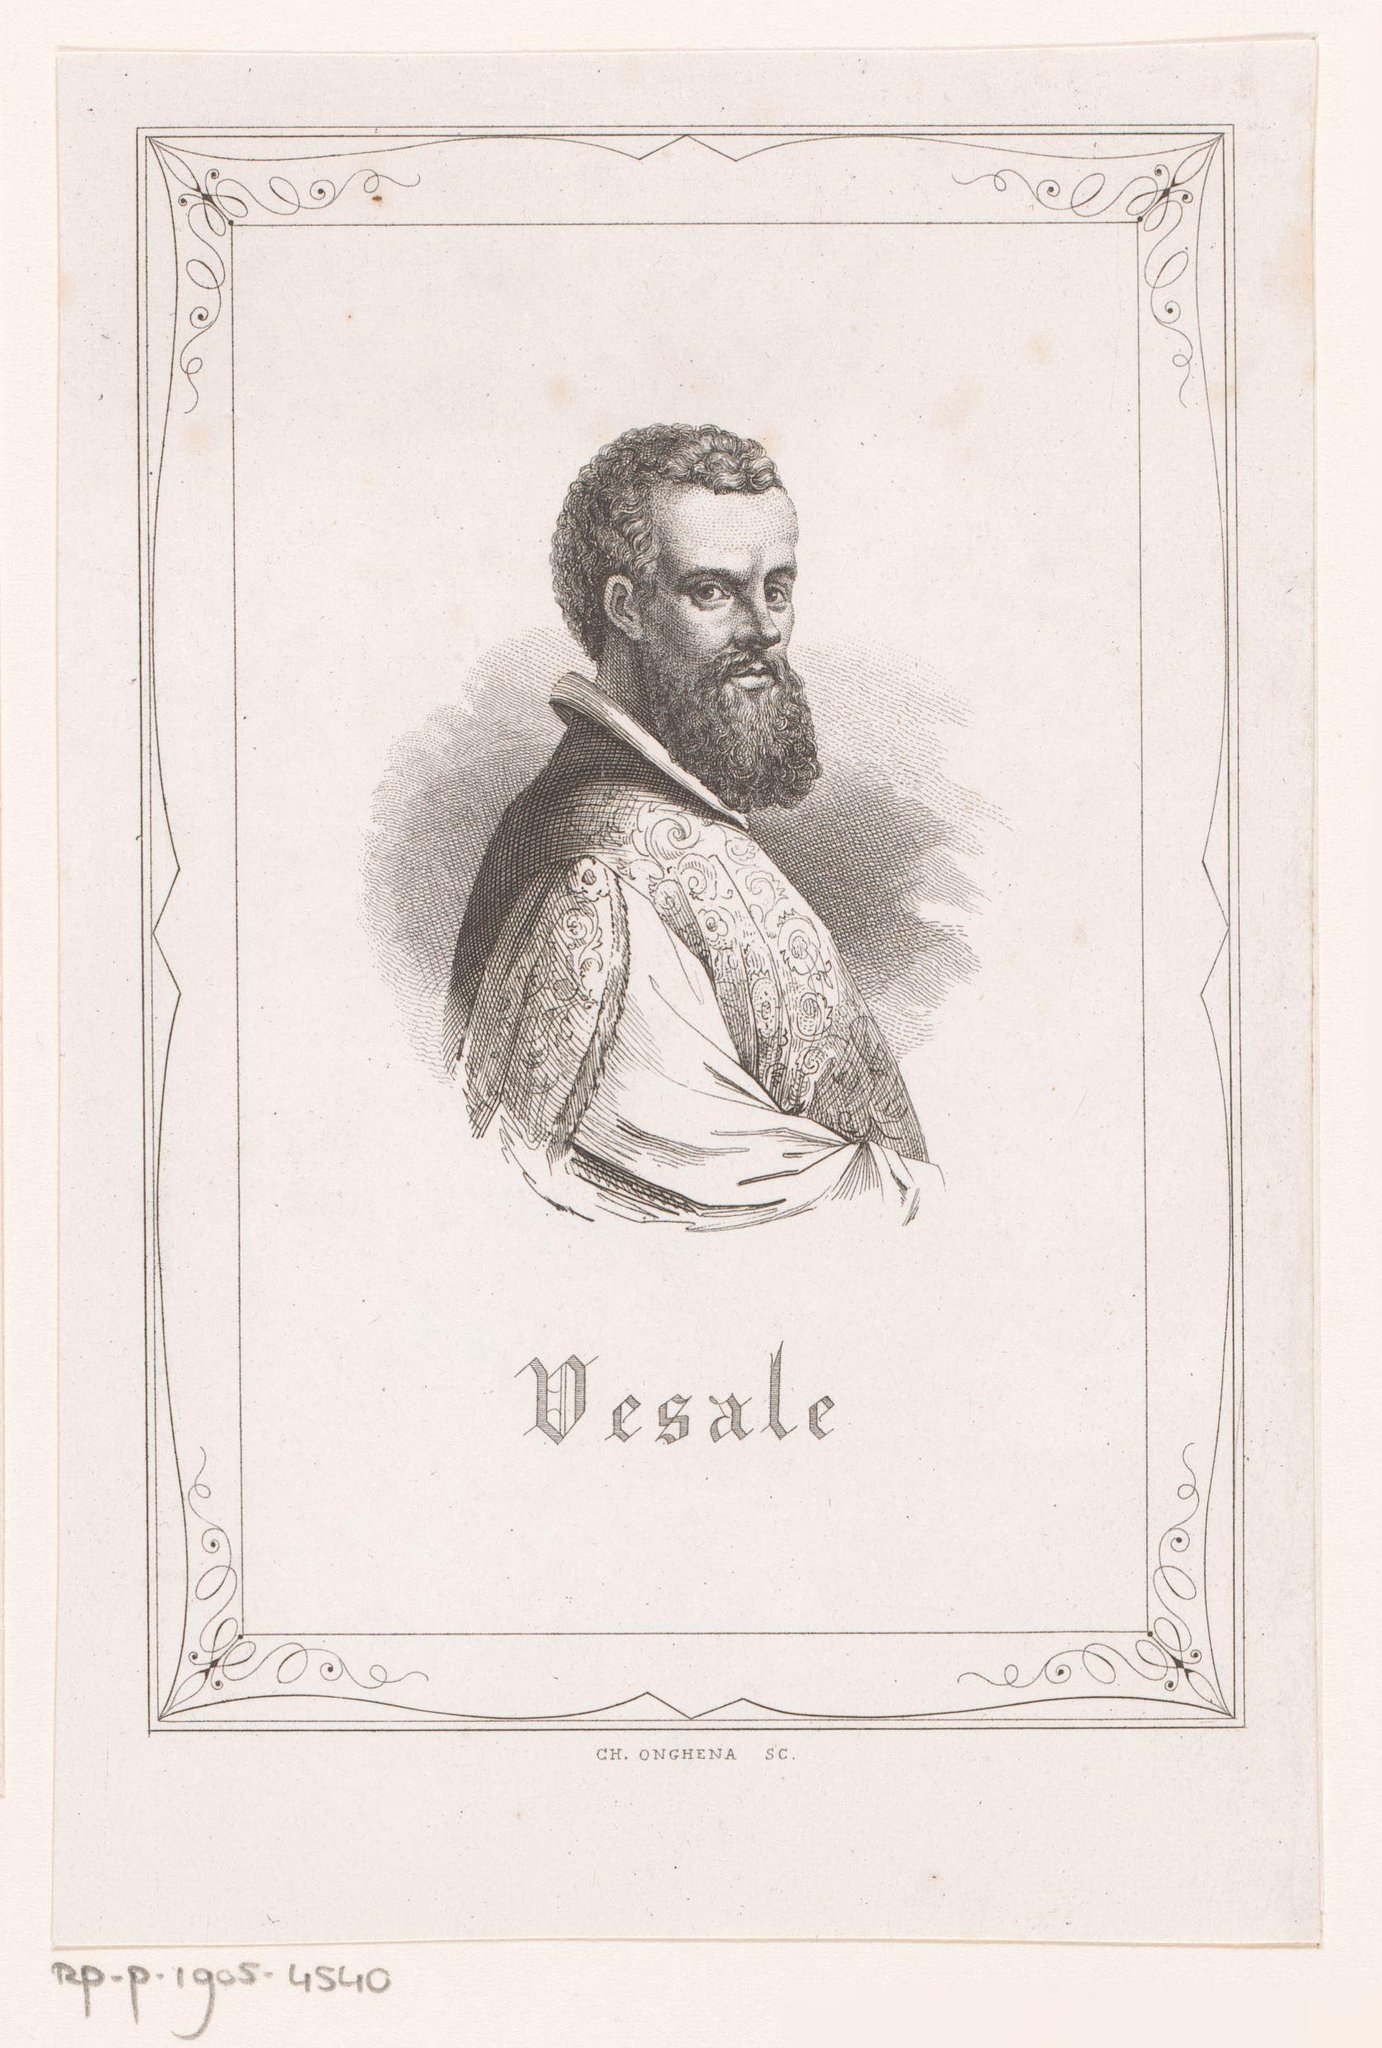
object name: print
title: Portret van Andreas Vesalius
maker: charles onghena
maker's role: print maker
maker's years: 1806-1886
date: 1816-1886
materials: paper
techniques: etching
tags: brussels, historical persons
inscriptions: collector's mark: Lugt 2228